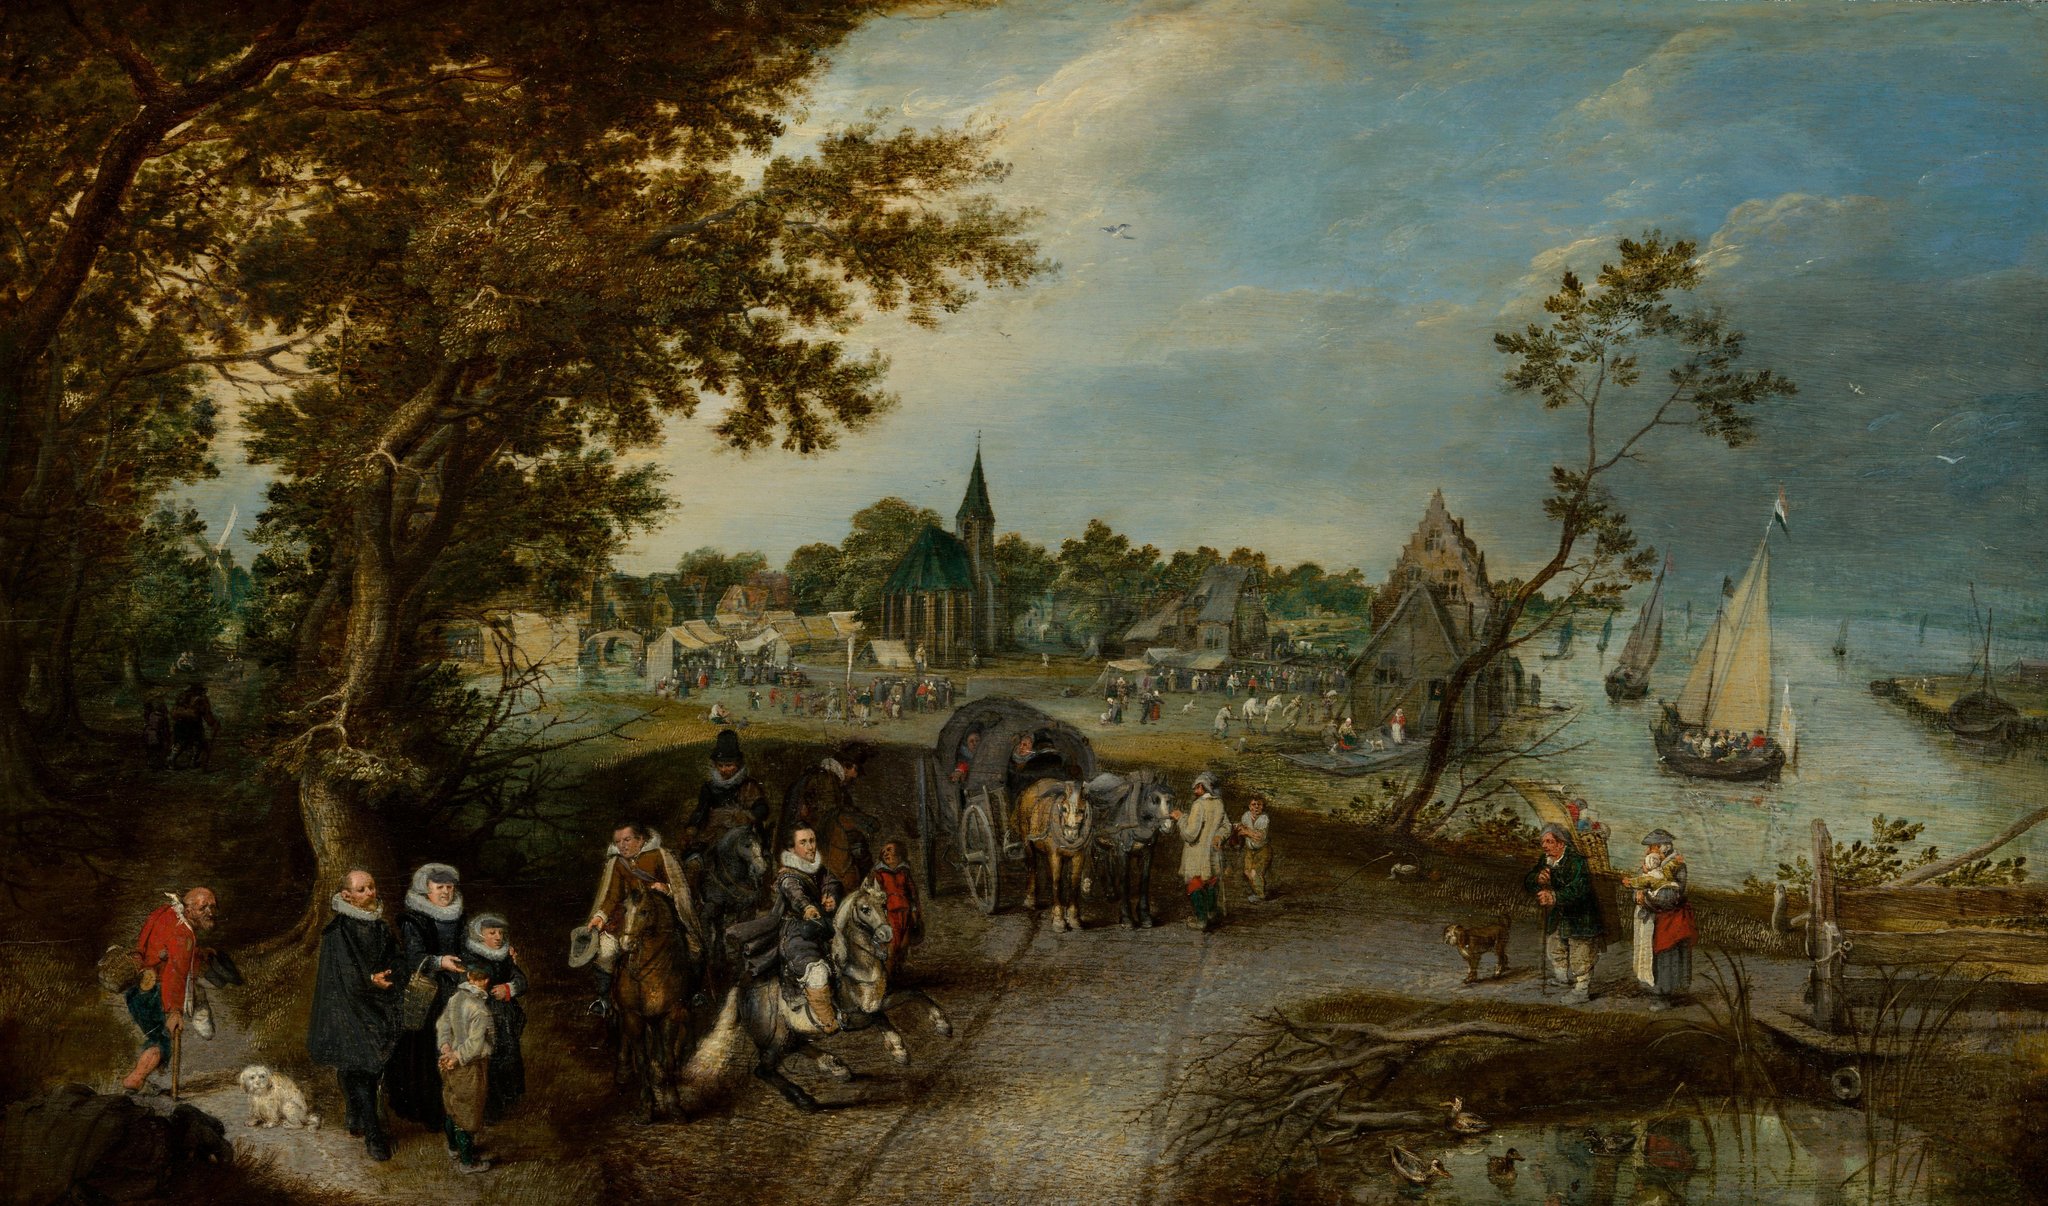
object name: painting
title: Landscape with Figures and a Village Fair (Village Kermesse)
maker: adriaen pietersz van de venne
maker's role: draughtsman, painter, print maker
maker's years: 1589-1662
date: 1615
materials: oil, panel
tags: river, village, pleasure fair and circus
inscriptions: signature and date, bottom right: ‘[...] NE 1615’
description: Landschap met figuren op de voorgrond, in de verte een dorpskermis. Op de voorgrond een bedelaar, een familie met twee kinderen, enkele ruiters en een huifkar met passagiers. In de verte een dorpsplein voor een kerk waar de stalletjes van een kermis staan opgesteld.